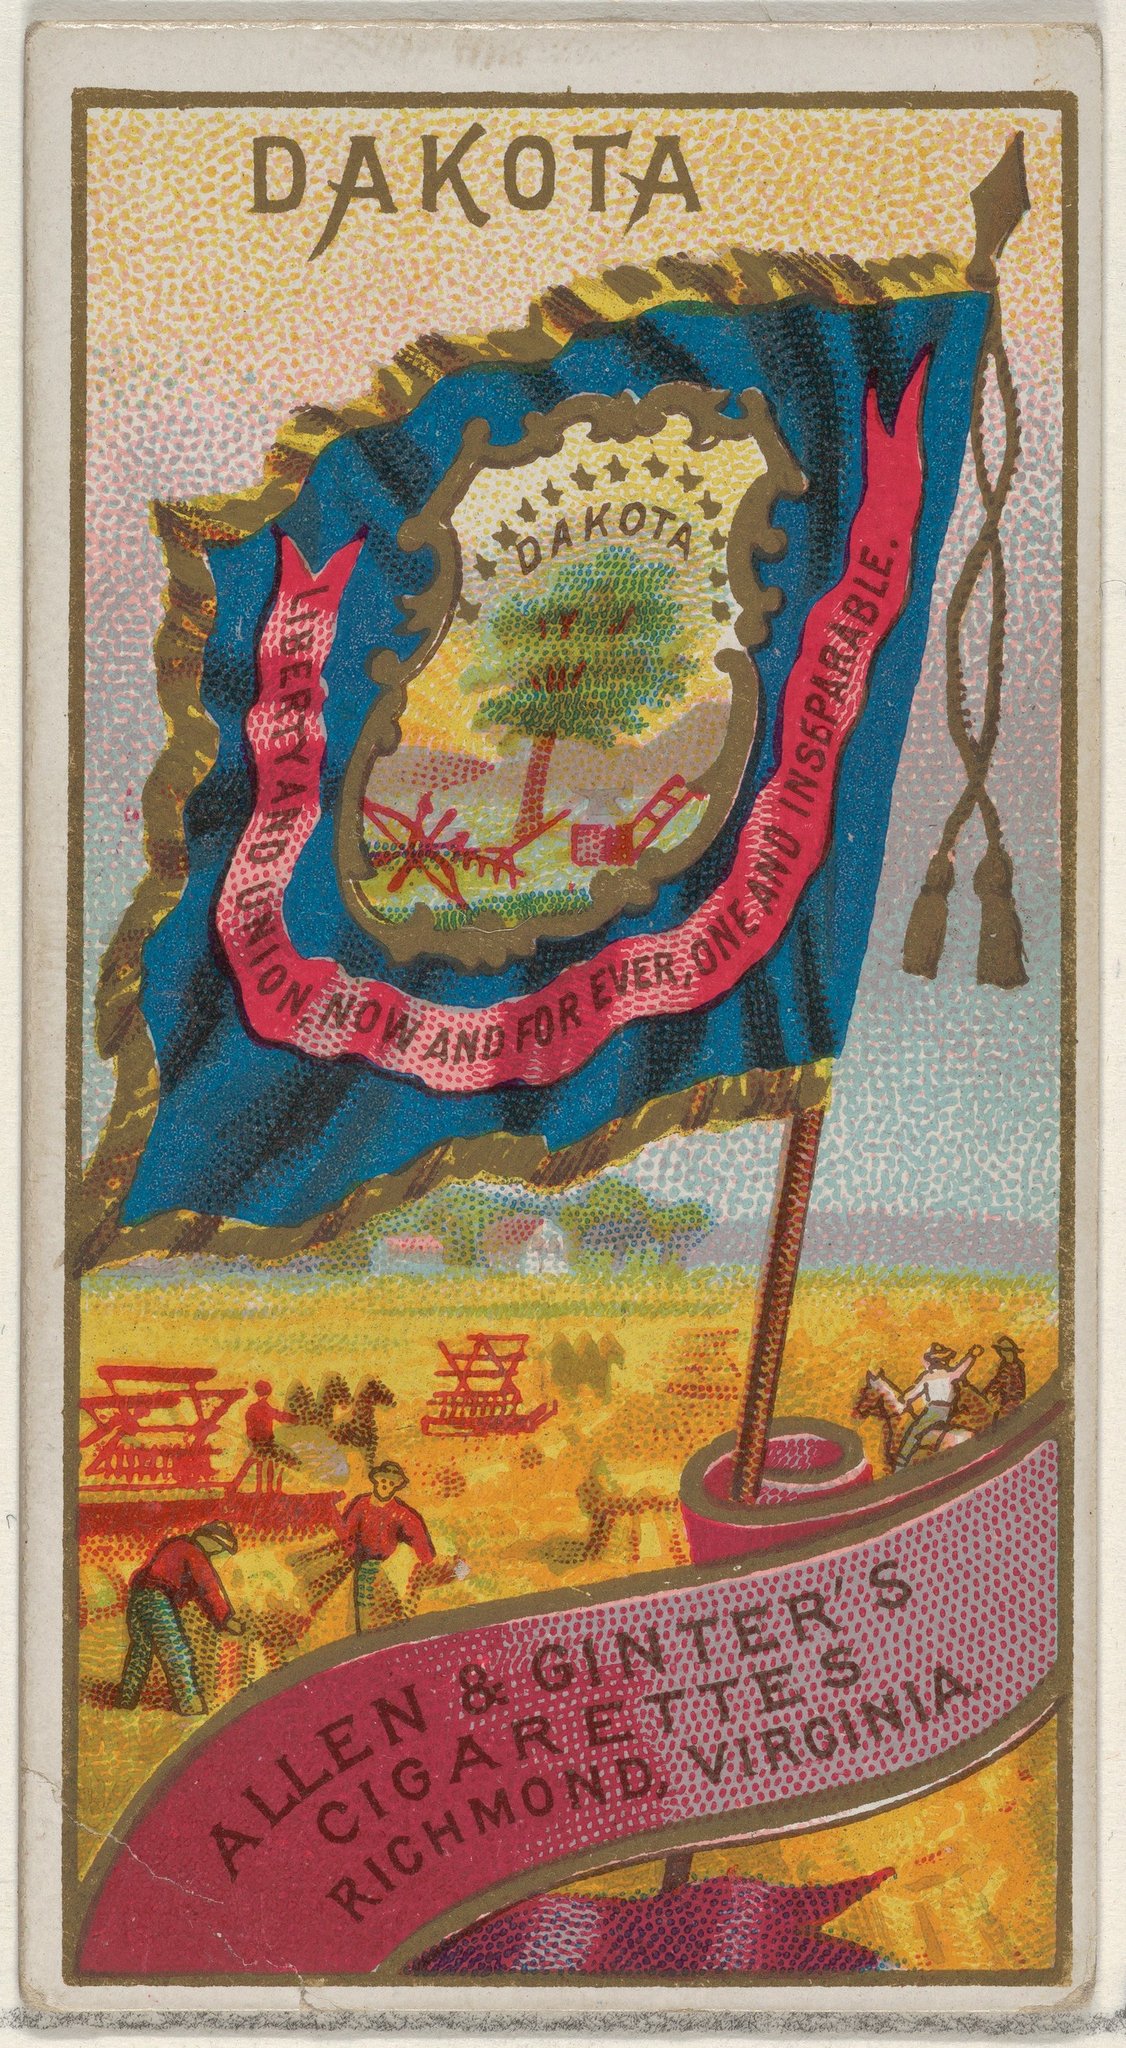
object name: print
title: Dakota, from Flags of the States and Territories (N11) for Allen & Ginter Cigarettes Brands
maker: allen & ginter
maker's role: publisher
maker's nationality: american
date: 1888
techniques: color lithograph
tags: flags